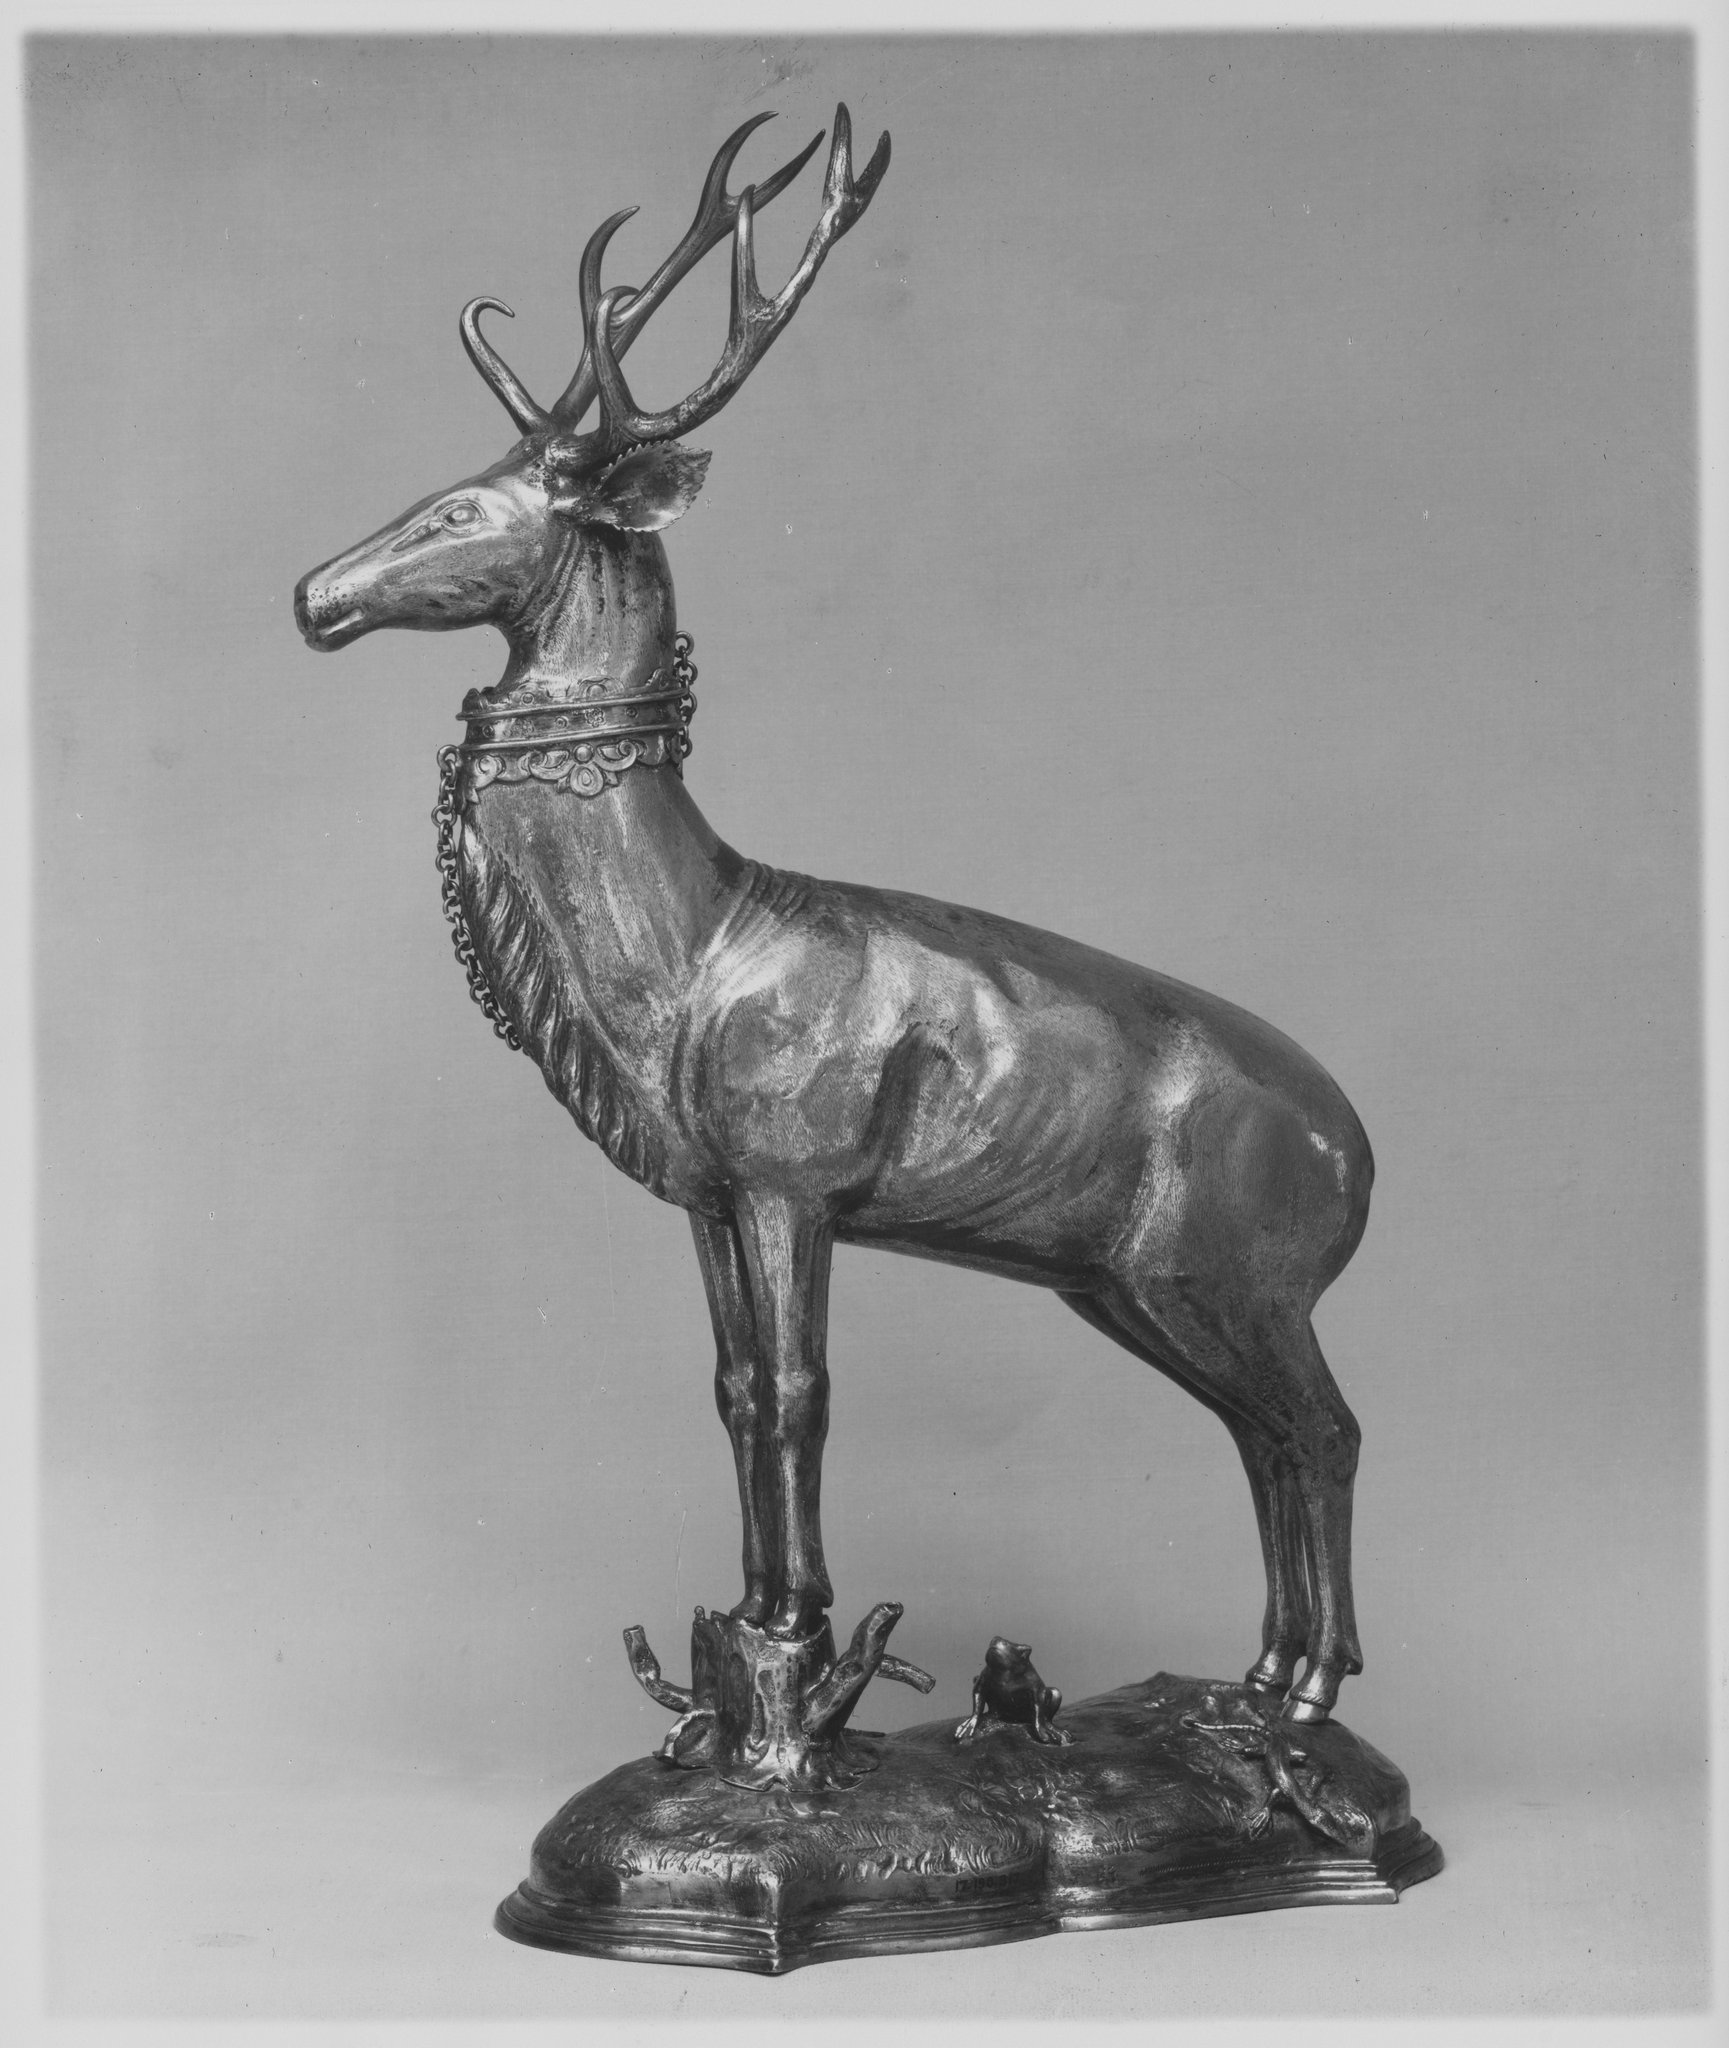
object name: cup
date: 1501-1600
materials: silver gilt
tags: deer